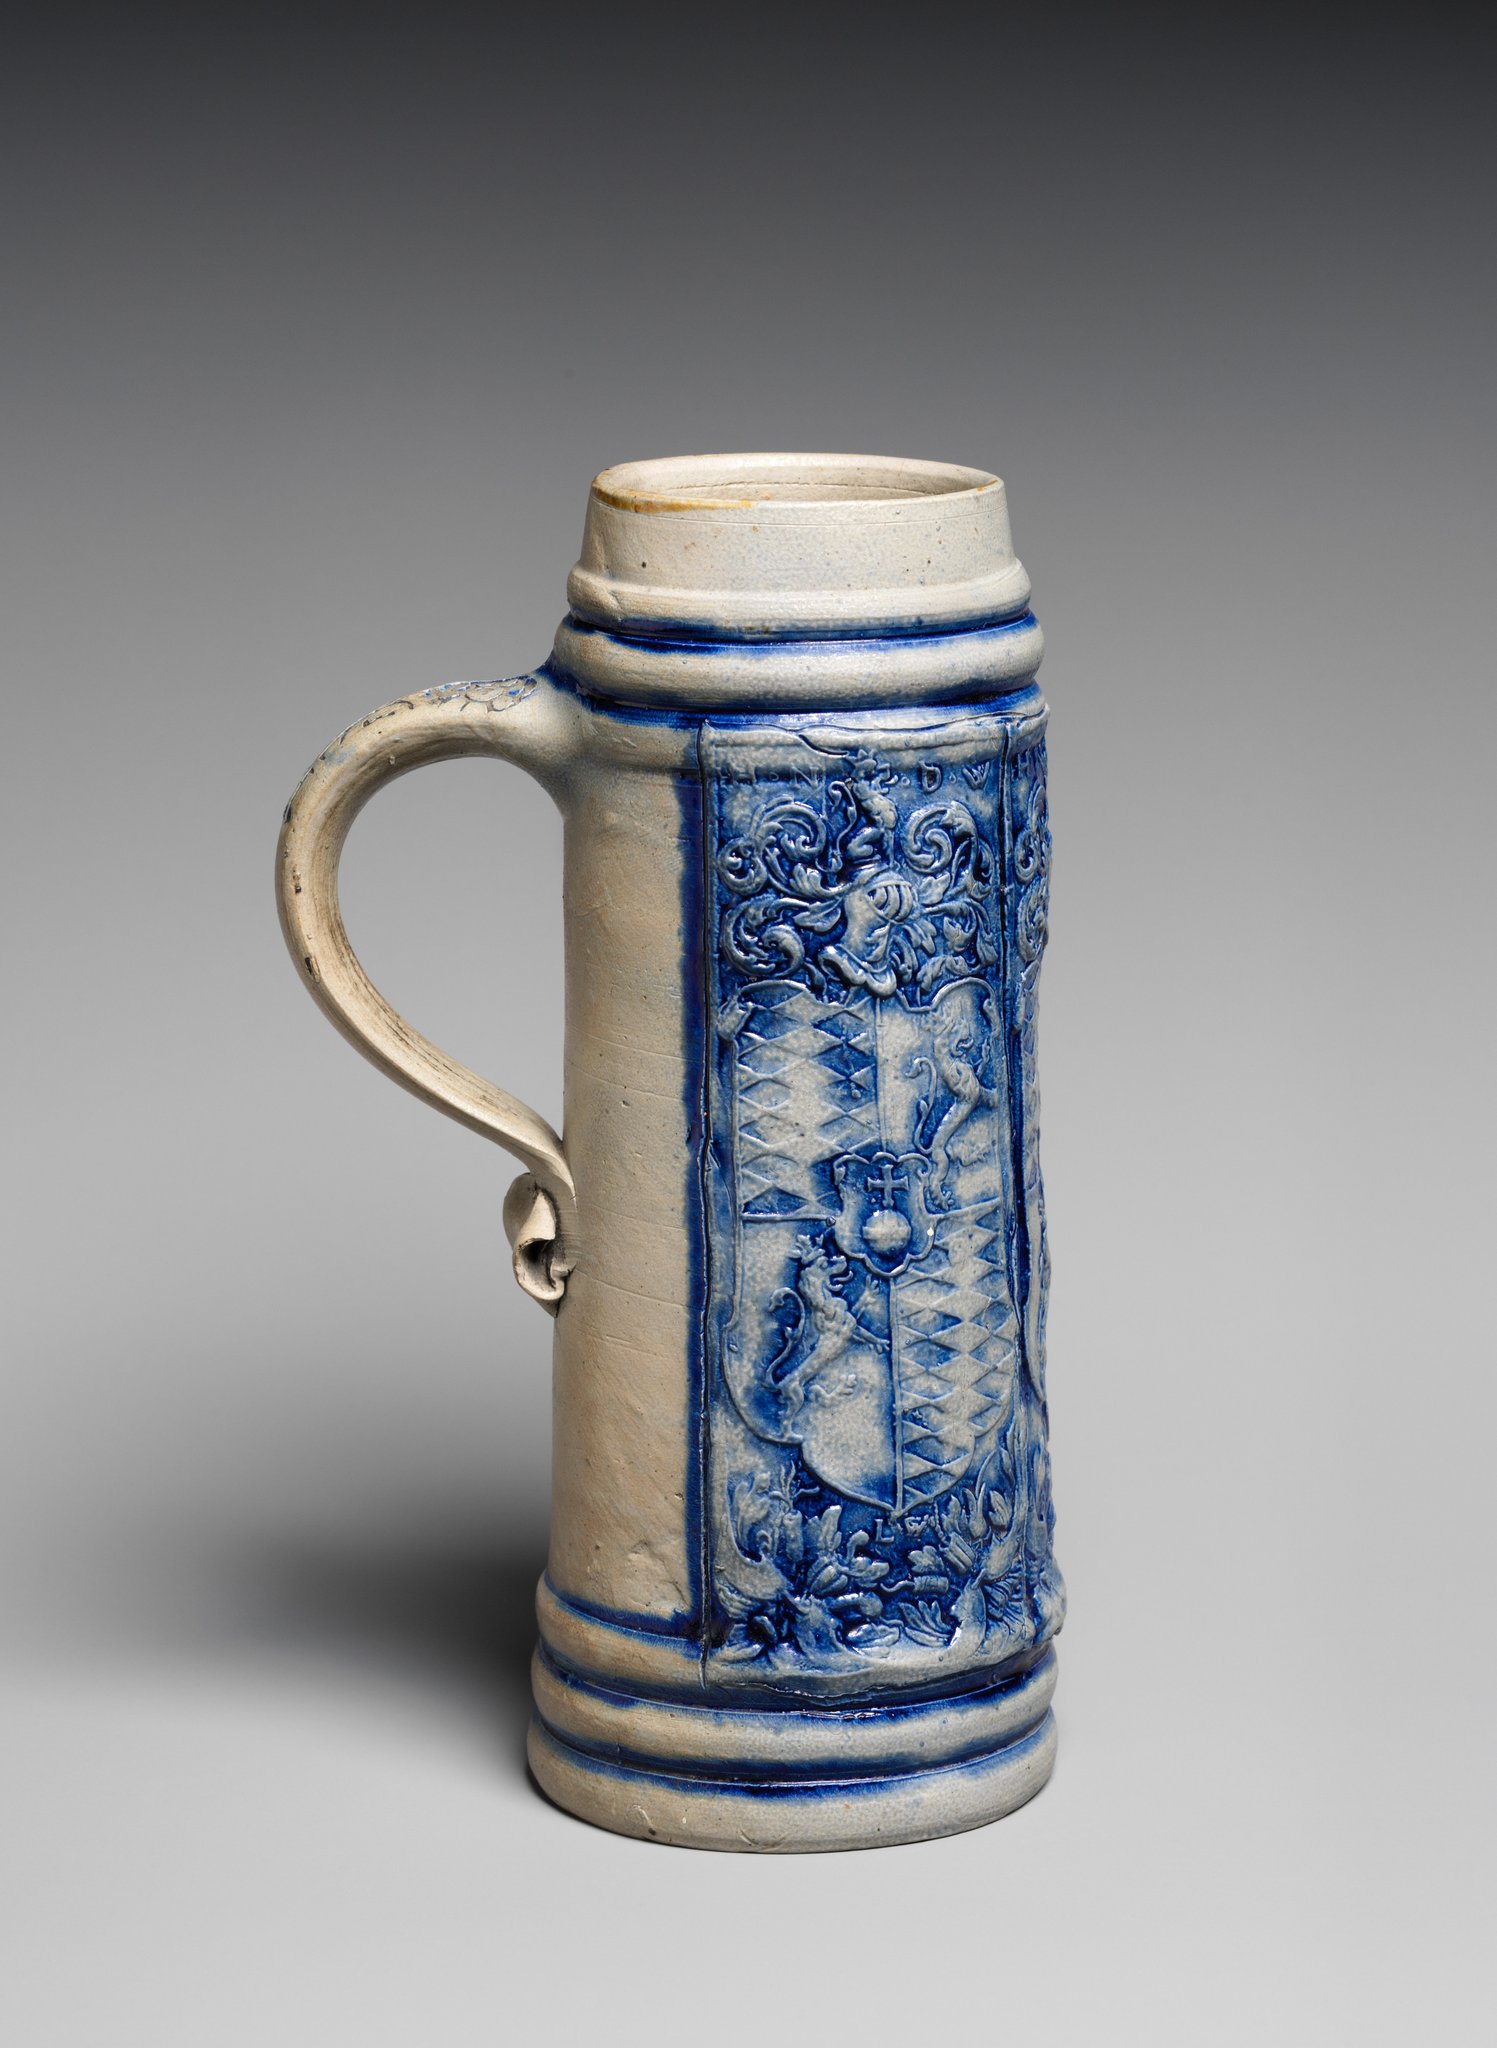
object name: tankard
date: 1625-1640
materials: stoneware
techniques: salt glaze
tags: lions